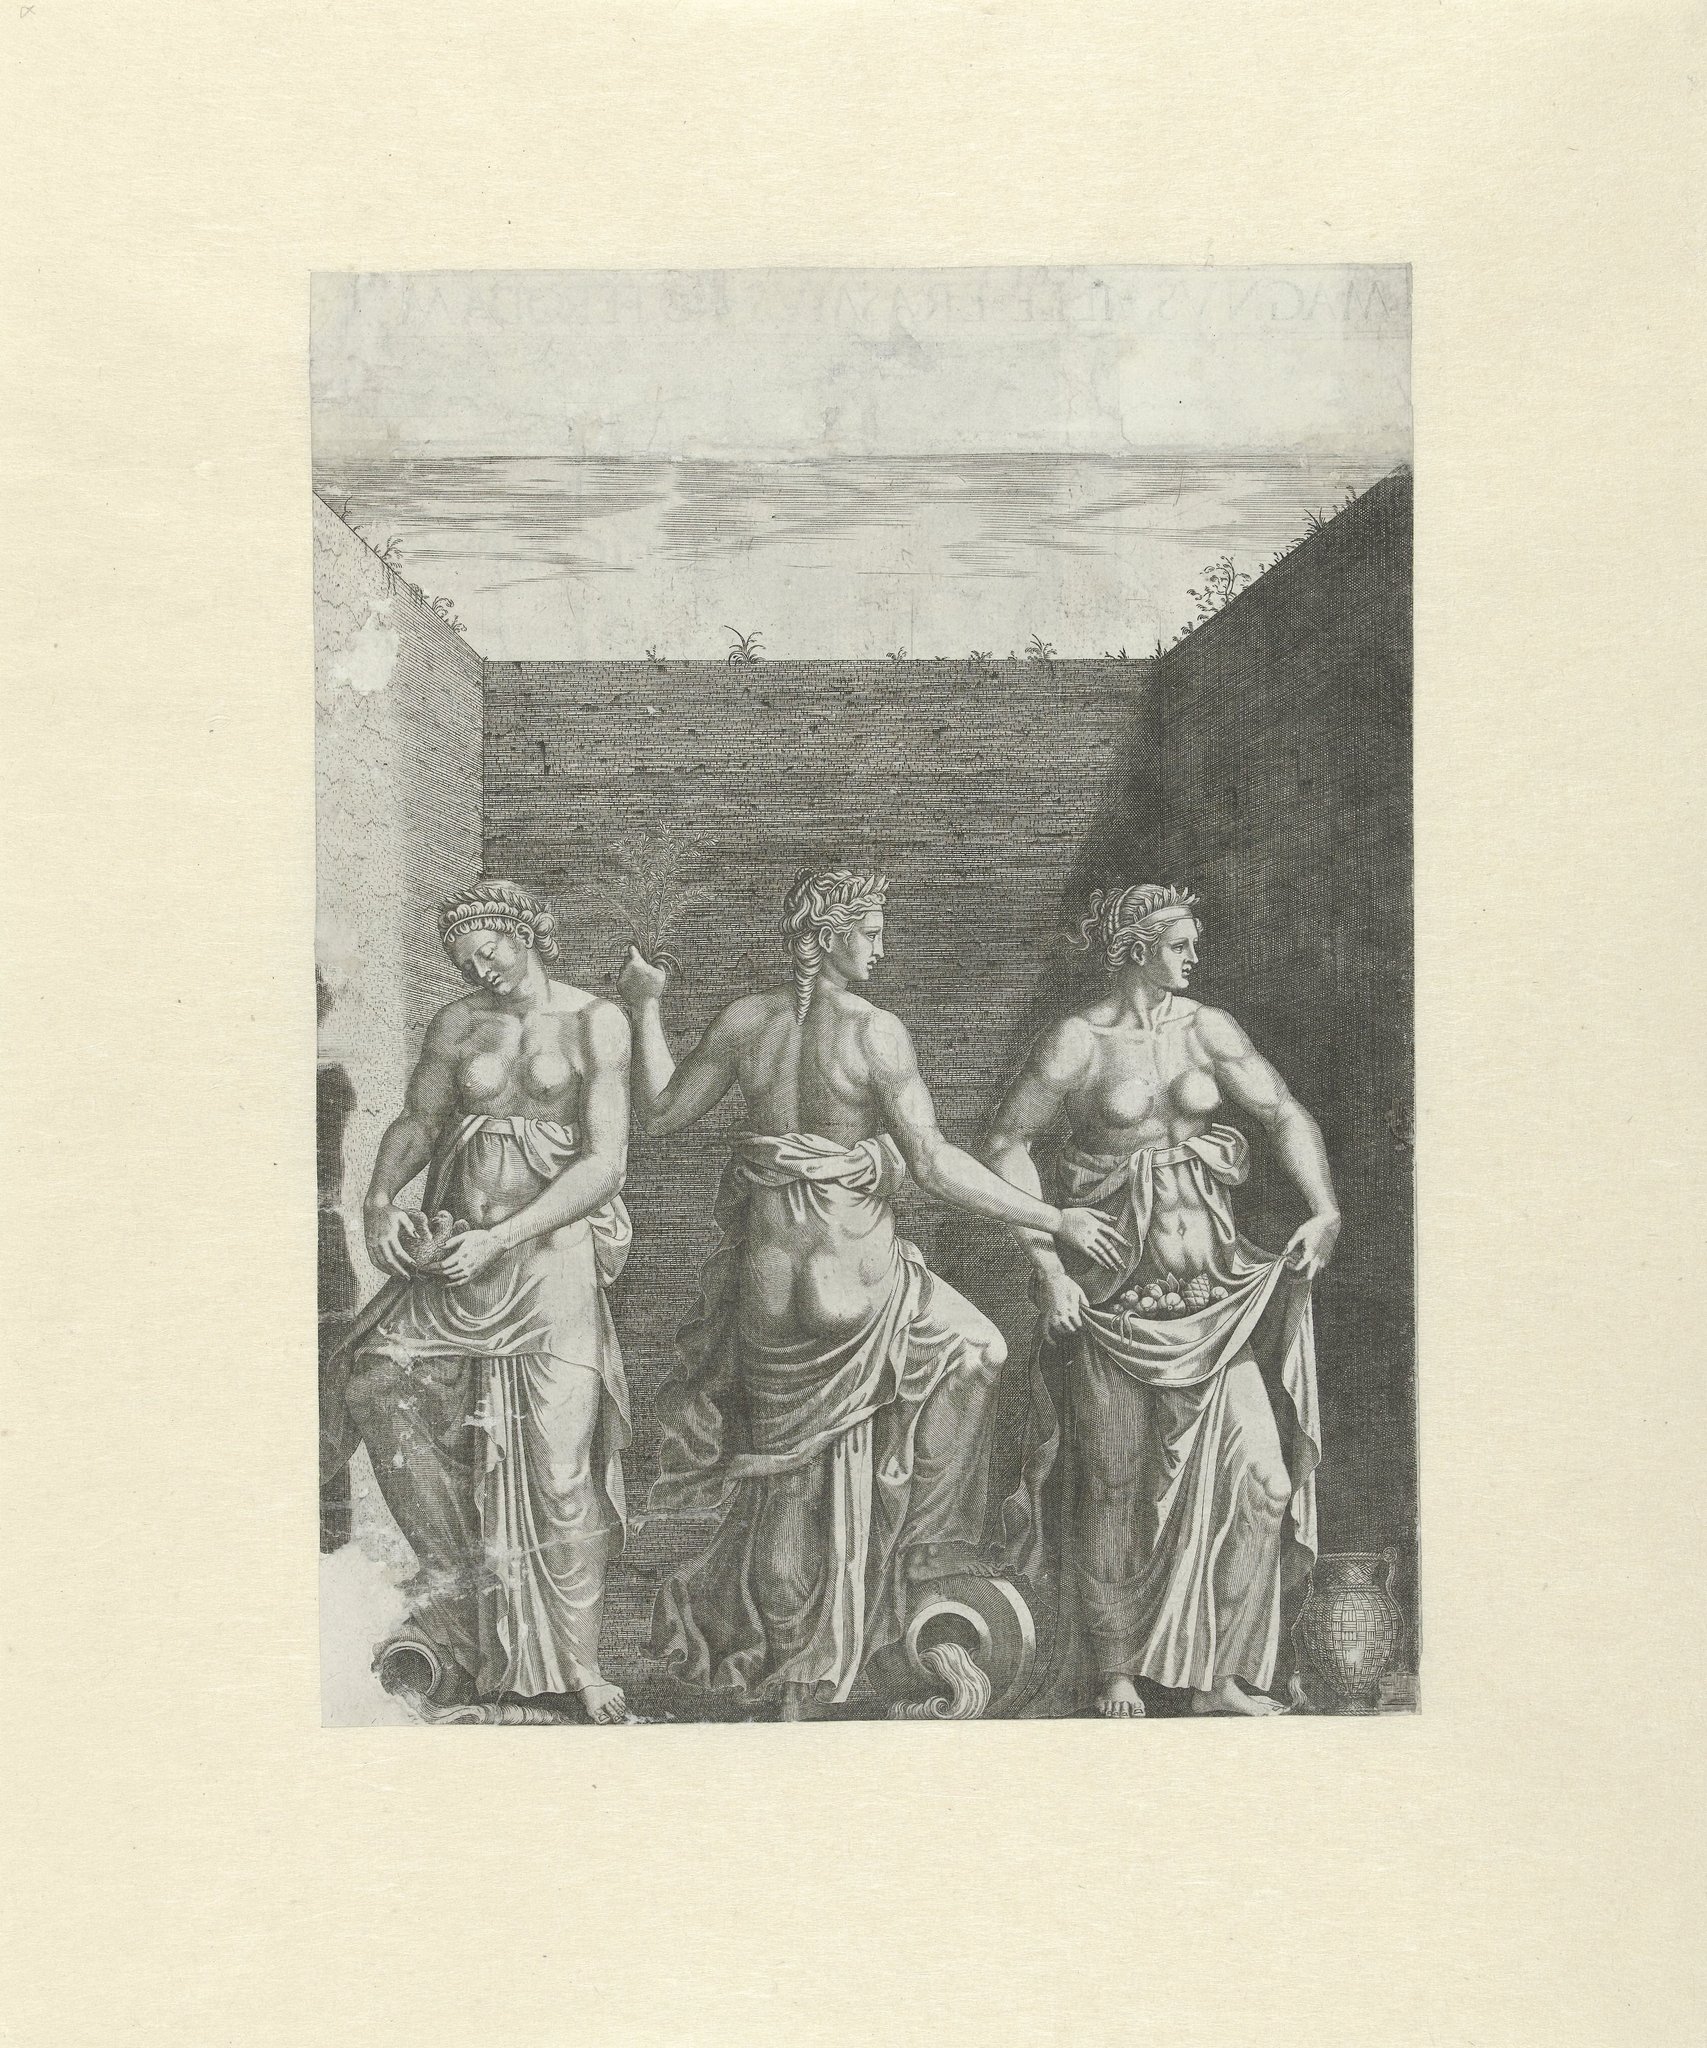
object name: print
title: De drie gratiën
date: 1528-1570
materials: paper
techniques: engraving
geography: antwerp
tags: graces (charites), generally three in number; 'gratie' (ripa)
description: De drie gratiën naast elkaar in een ommuurde hof. De gratie links houdt een vogel in haar handen, de middelste, op de rug gezien, houdt gebladerde takken in haar hand, de gratie rechts met vruchten in haar gewaad.